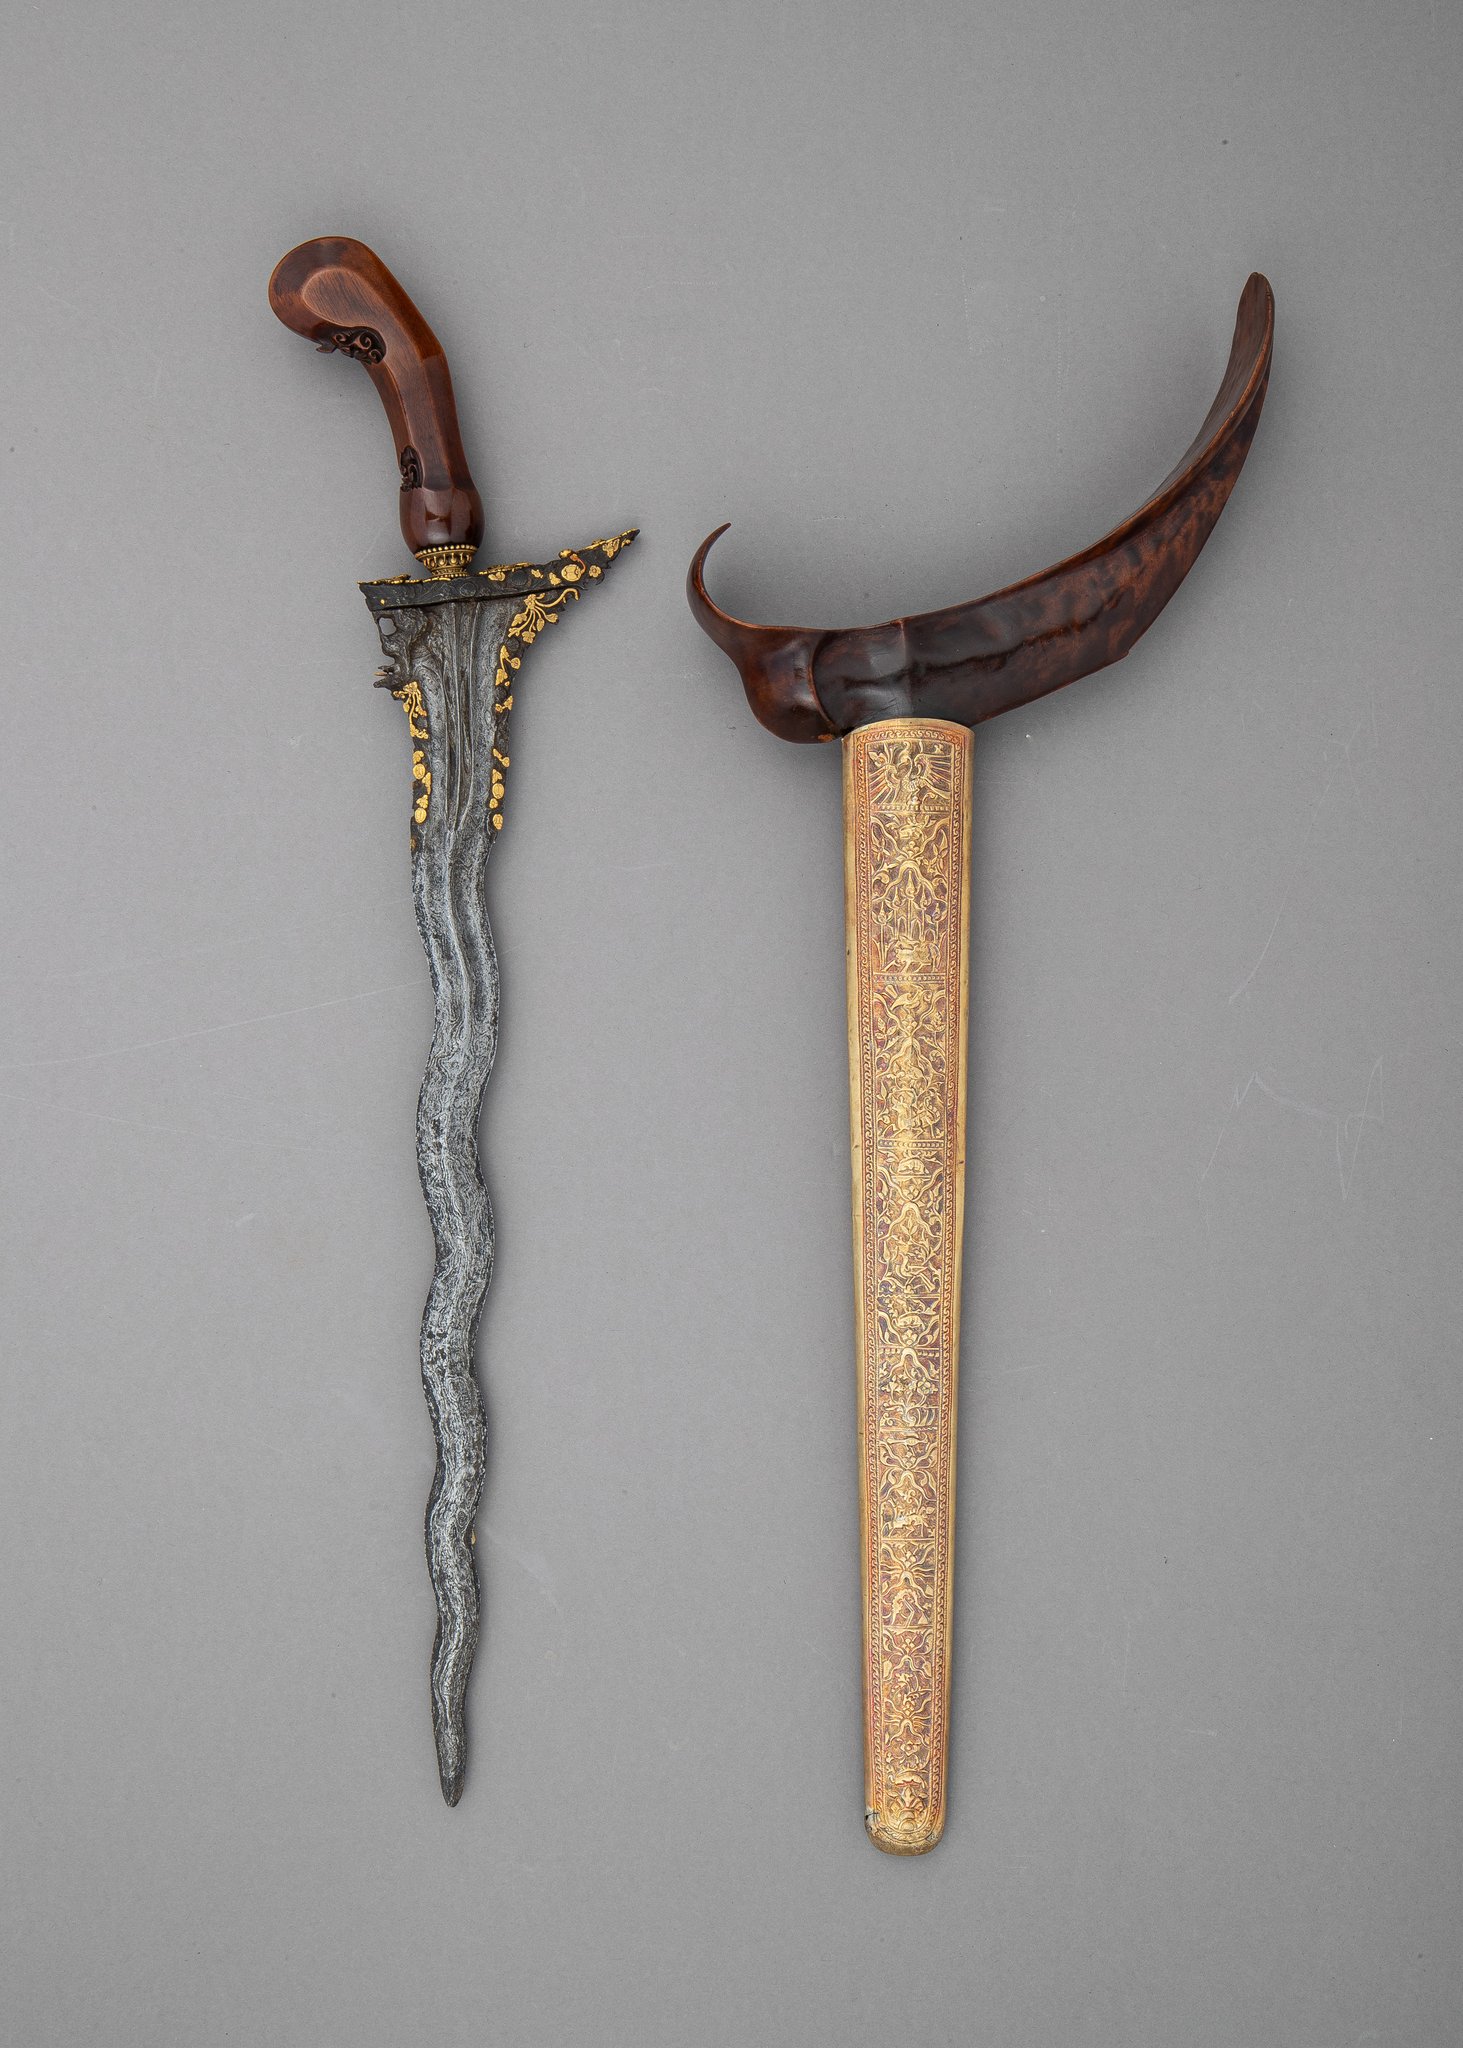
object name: kris with sheath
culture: javanese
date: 1501-1900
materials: gold, steel, wood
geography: indonesia